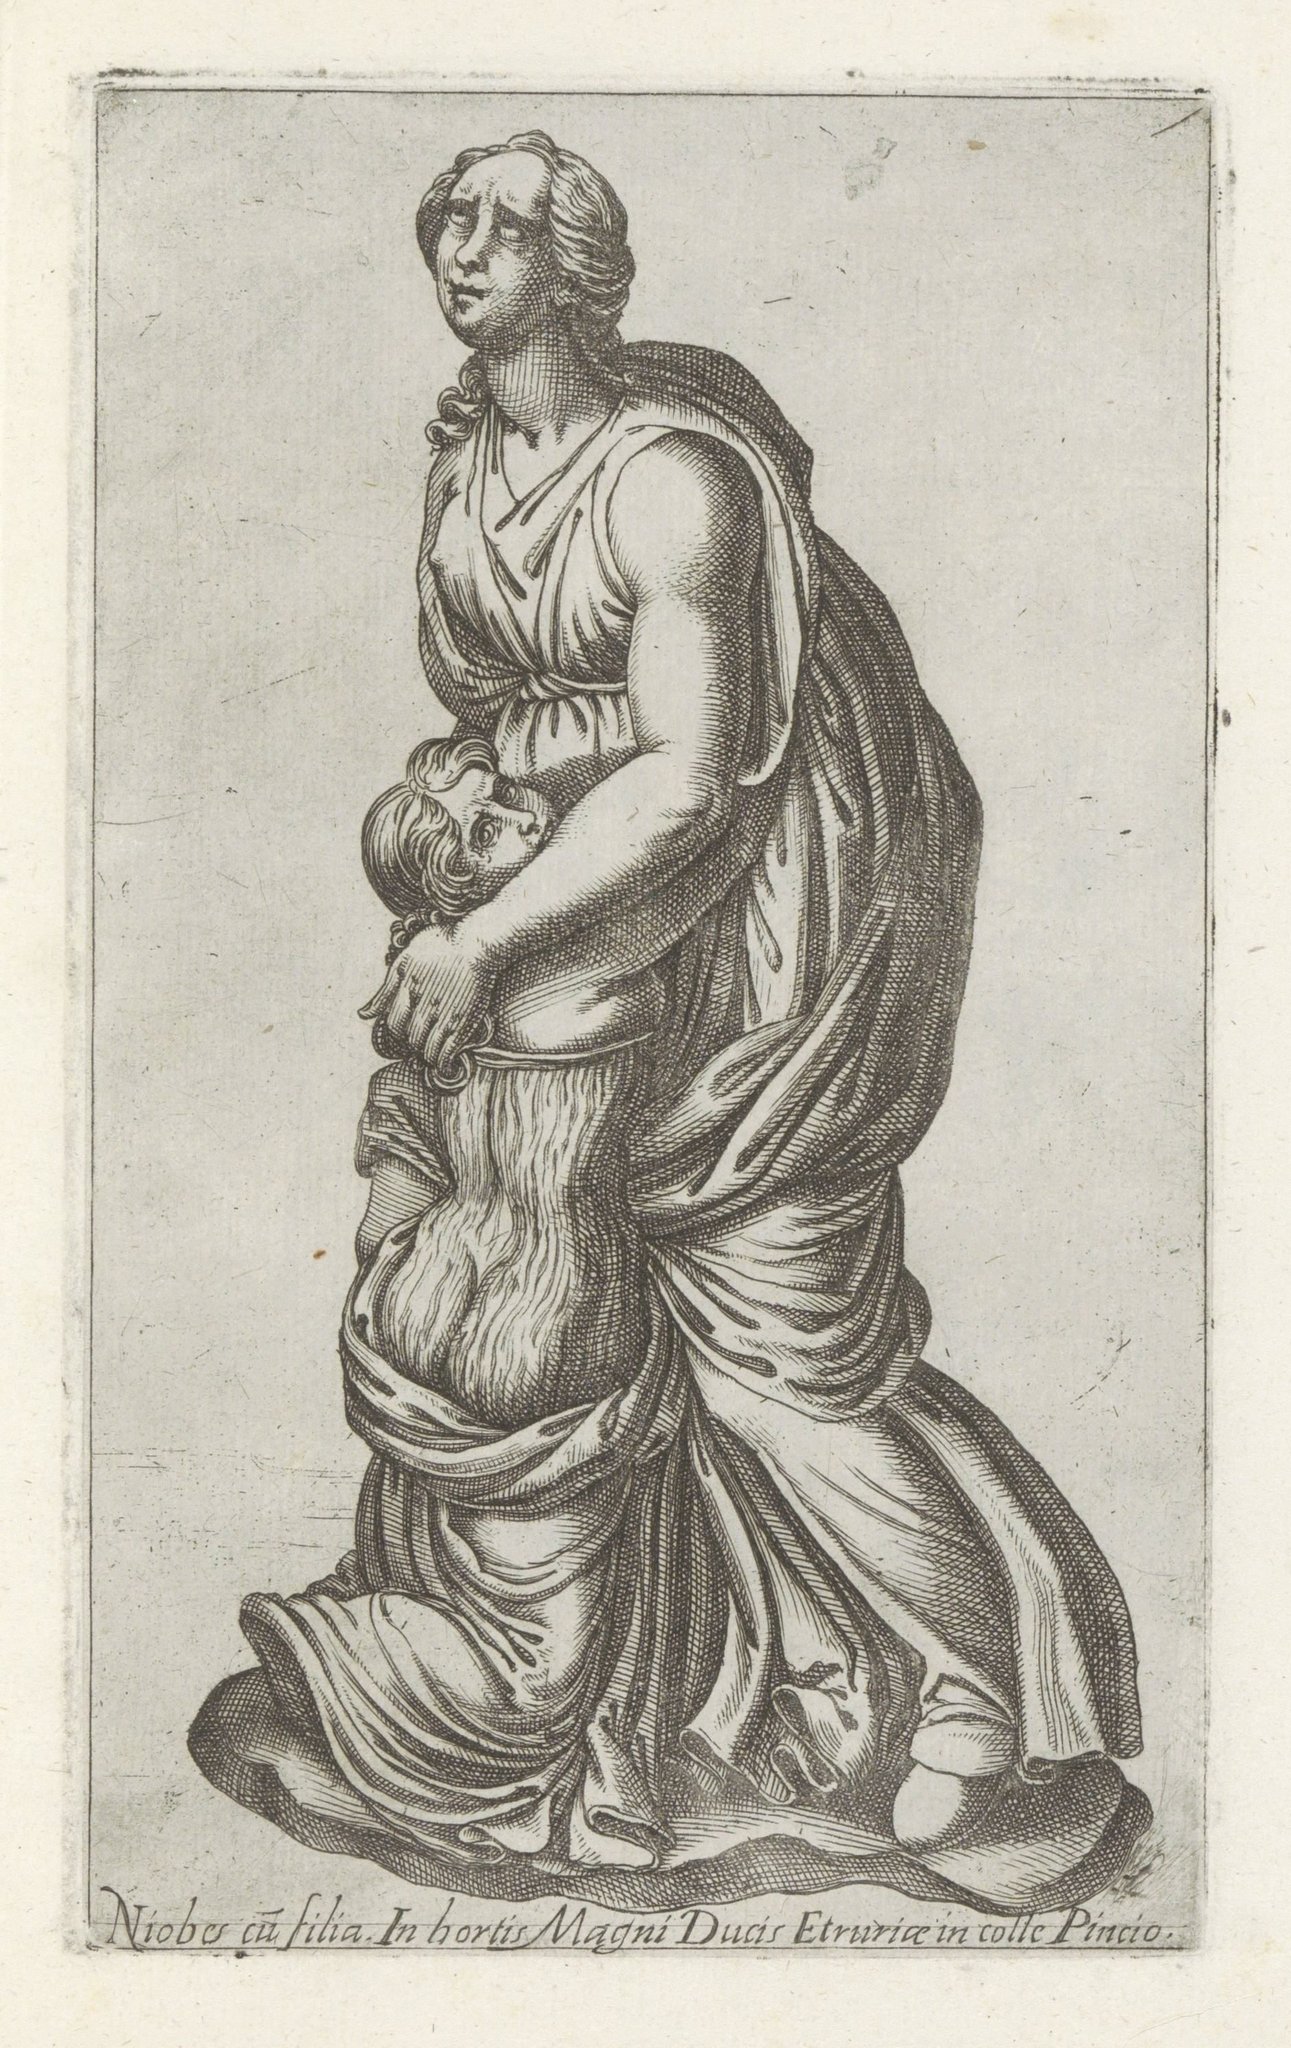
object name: album leaf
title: Sculptuur van Niobe met haar dochter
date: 1584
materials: paper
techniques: engraving, intaglio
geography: rome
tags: piece of sculpture, reproduction of a piece of sculpture, (story of) niobe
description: Deze prent maakt deel uit van een set van 79 prenten (+ titelprent) met voorstellingen van antieke sculpturen in Rome.